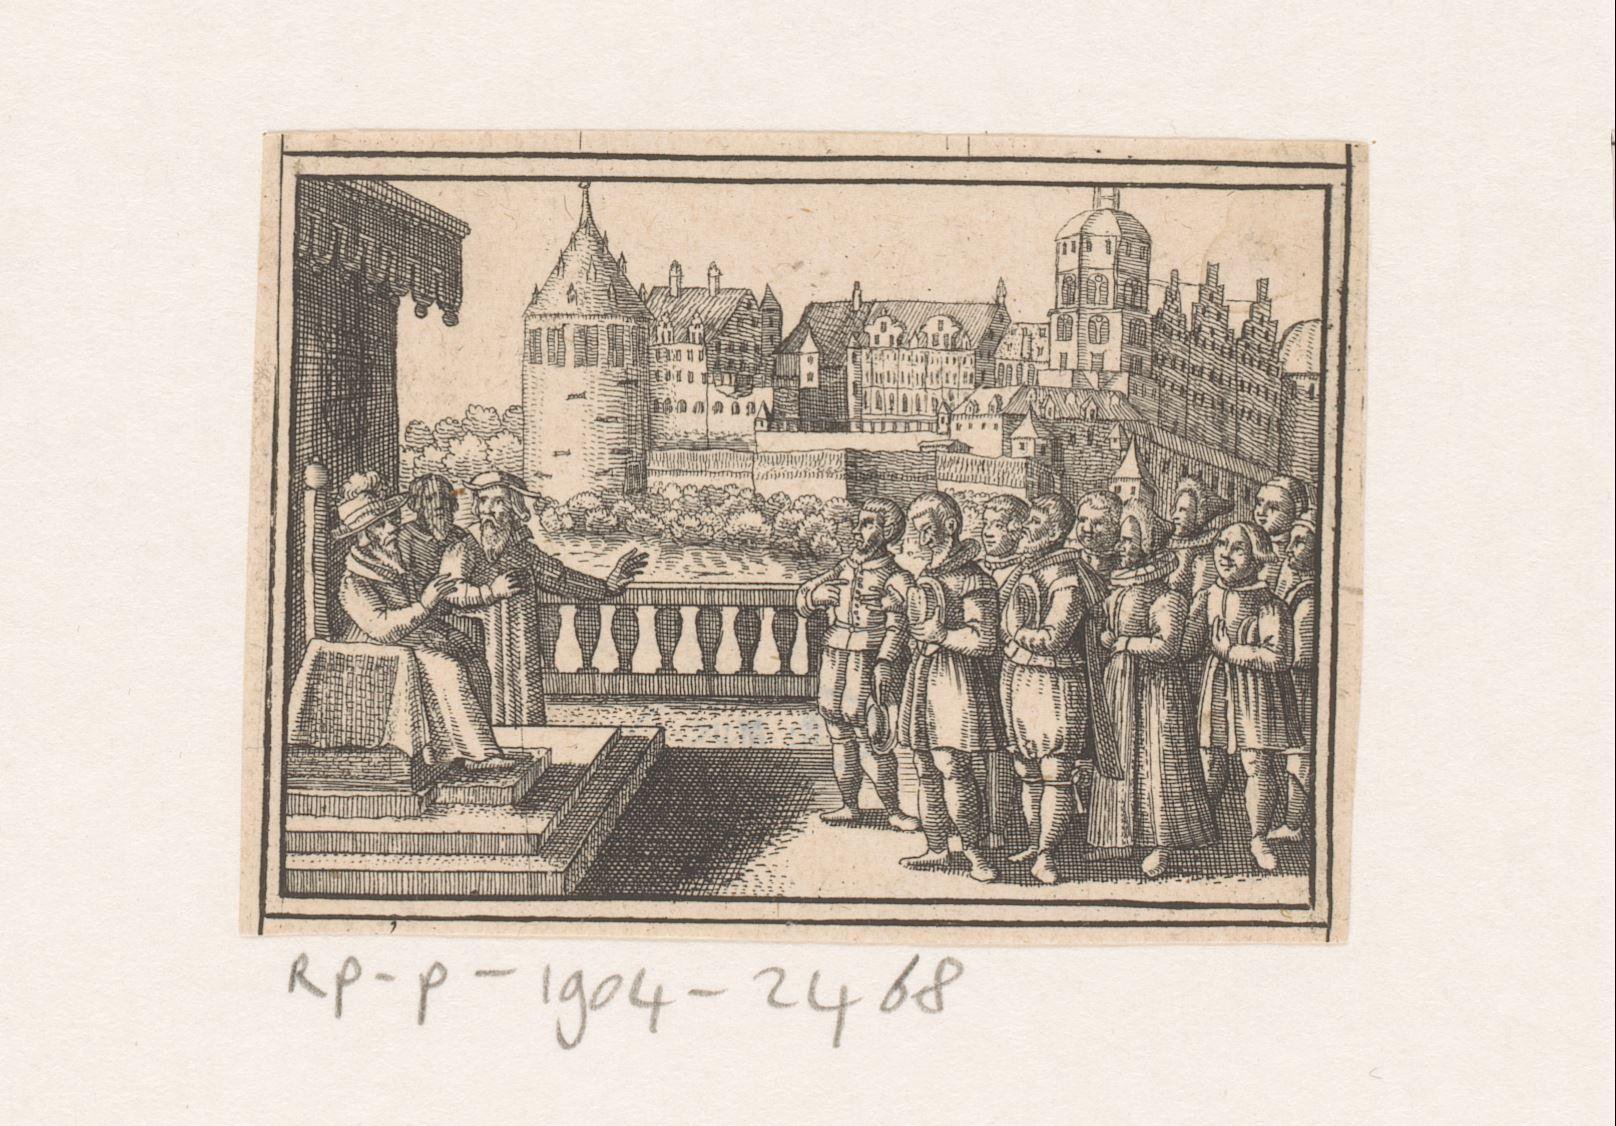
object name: book illustration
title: Audiëntie bij een vorst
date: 1624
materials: paper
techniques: etching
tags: city-view, and landscape with man-made constructions, castle, audition; ruler giving audience - bb - female ruler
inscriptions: collector's mark: Lugt 2228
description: Prent uit: Sudermann, Daniel. Centuria Similitudinum, Hubert Gleichnussen. Straatsburg, Jacob van der Heyden, 1624. (Hollstein German XXVIA 646).